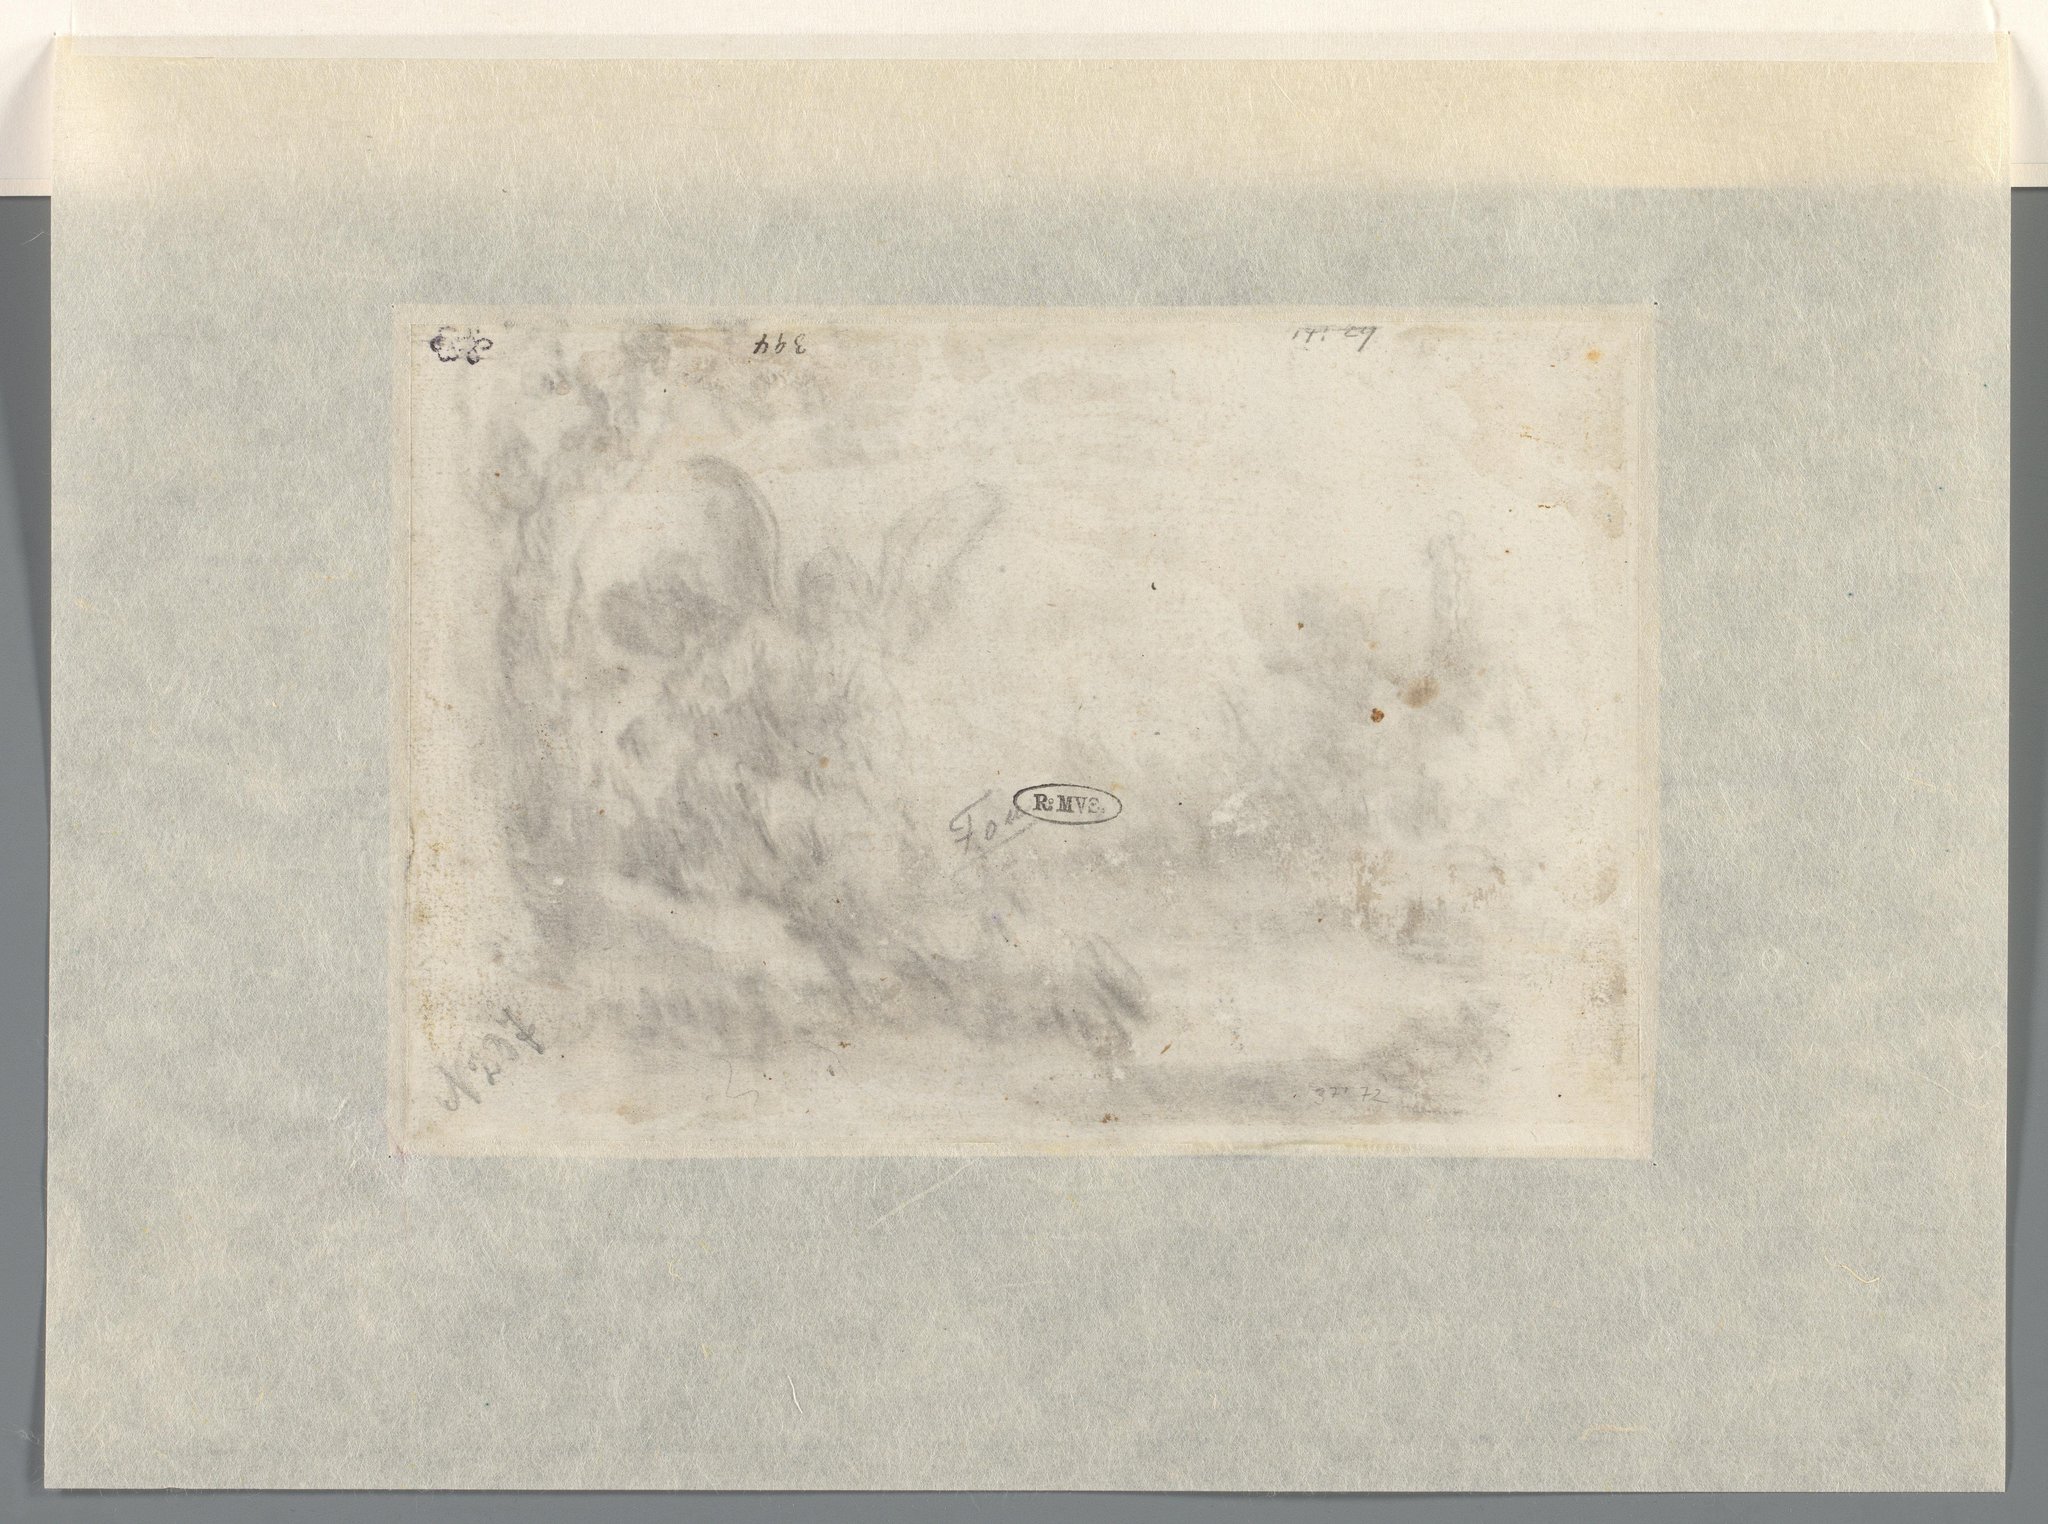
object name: drawing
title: Knielende engel bij een boom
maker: claes moeyaert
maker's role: draughtsman, painter, print maker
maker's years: 1592-1655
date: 1602-1655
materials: chalk, paper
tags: lower angel(s)